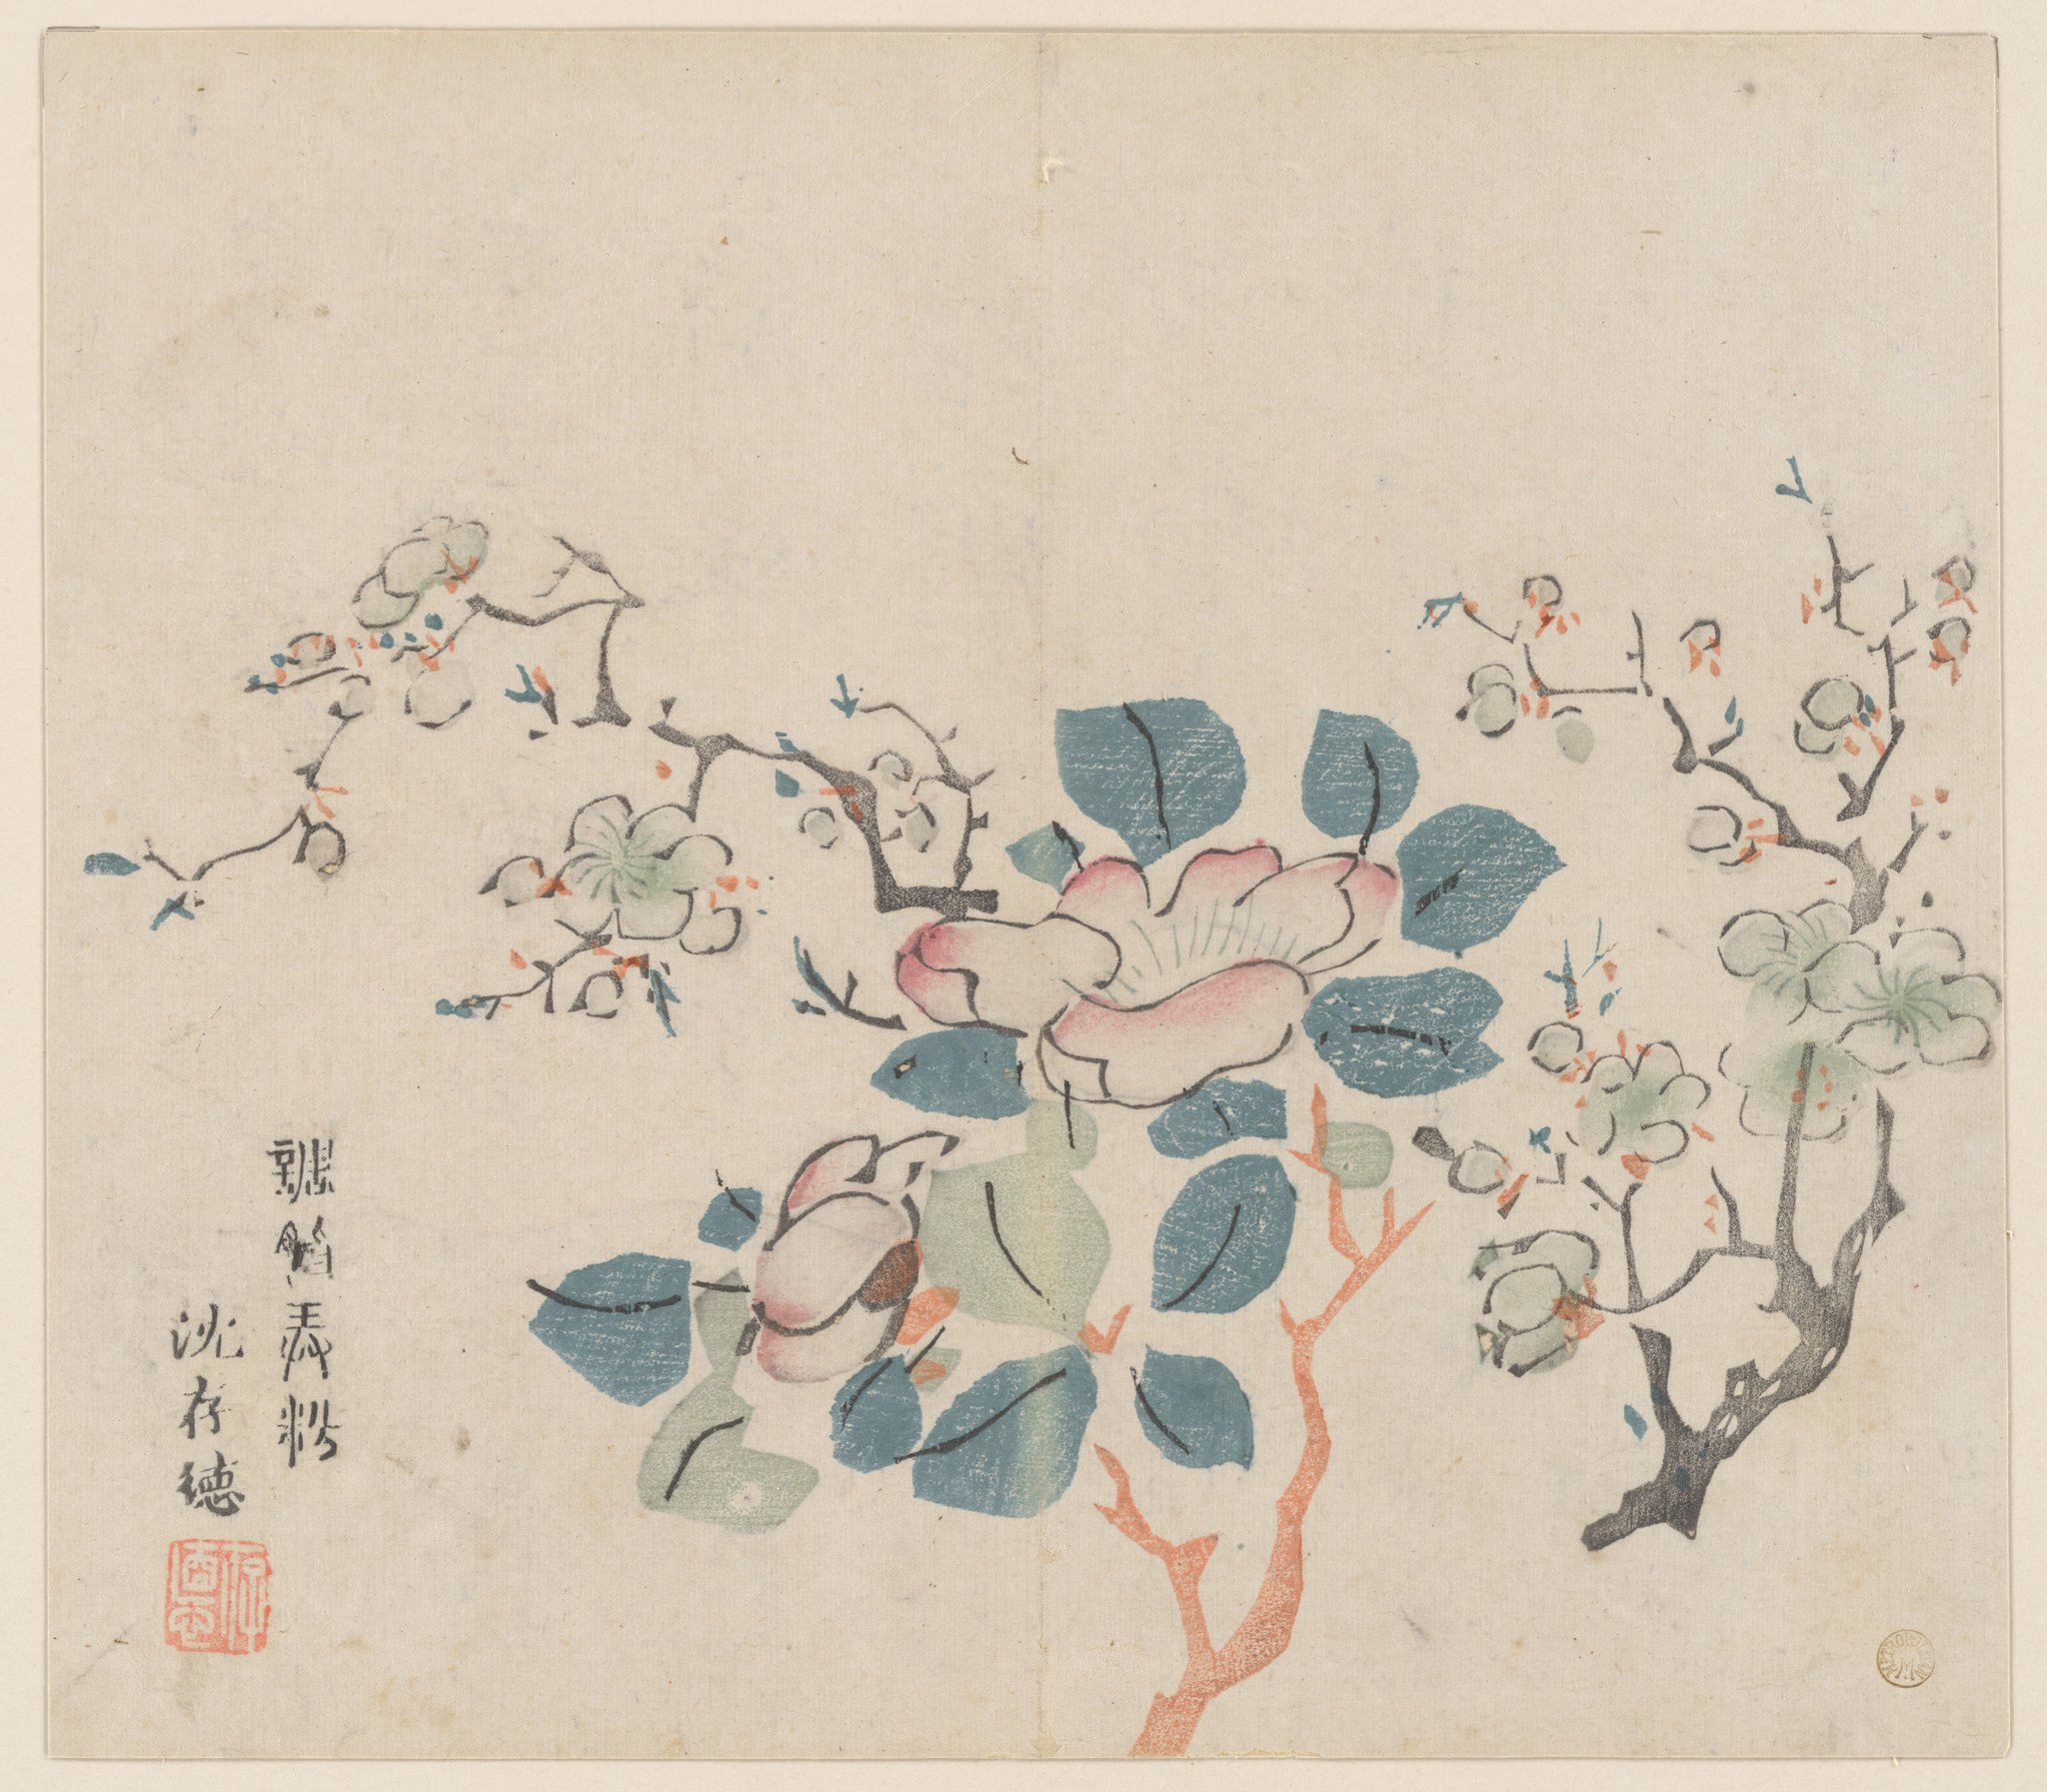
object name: print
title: Page from the Ten Bamboo Studio Manual of Painting and Calligraphy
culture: chinese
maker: hu zhengyan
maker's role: artist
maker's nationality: chinese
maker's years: 1584-1634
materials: ink, paper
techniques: printing